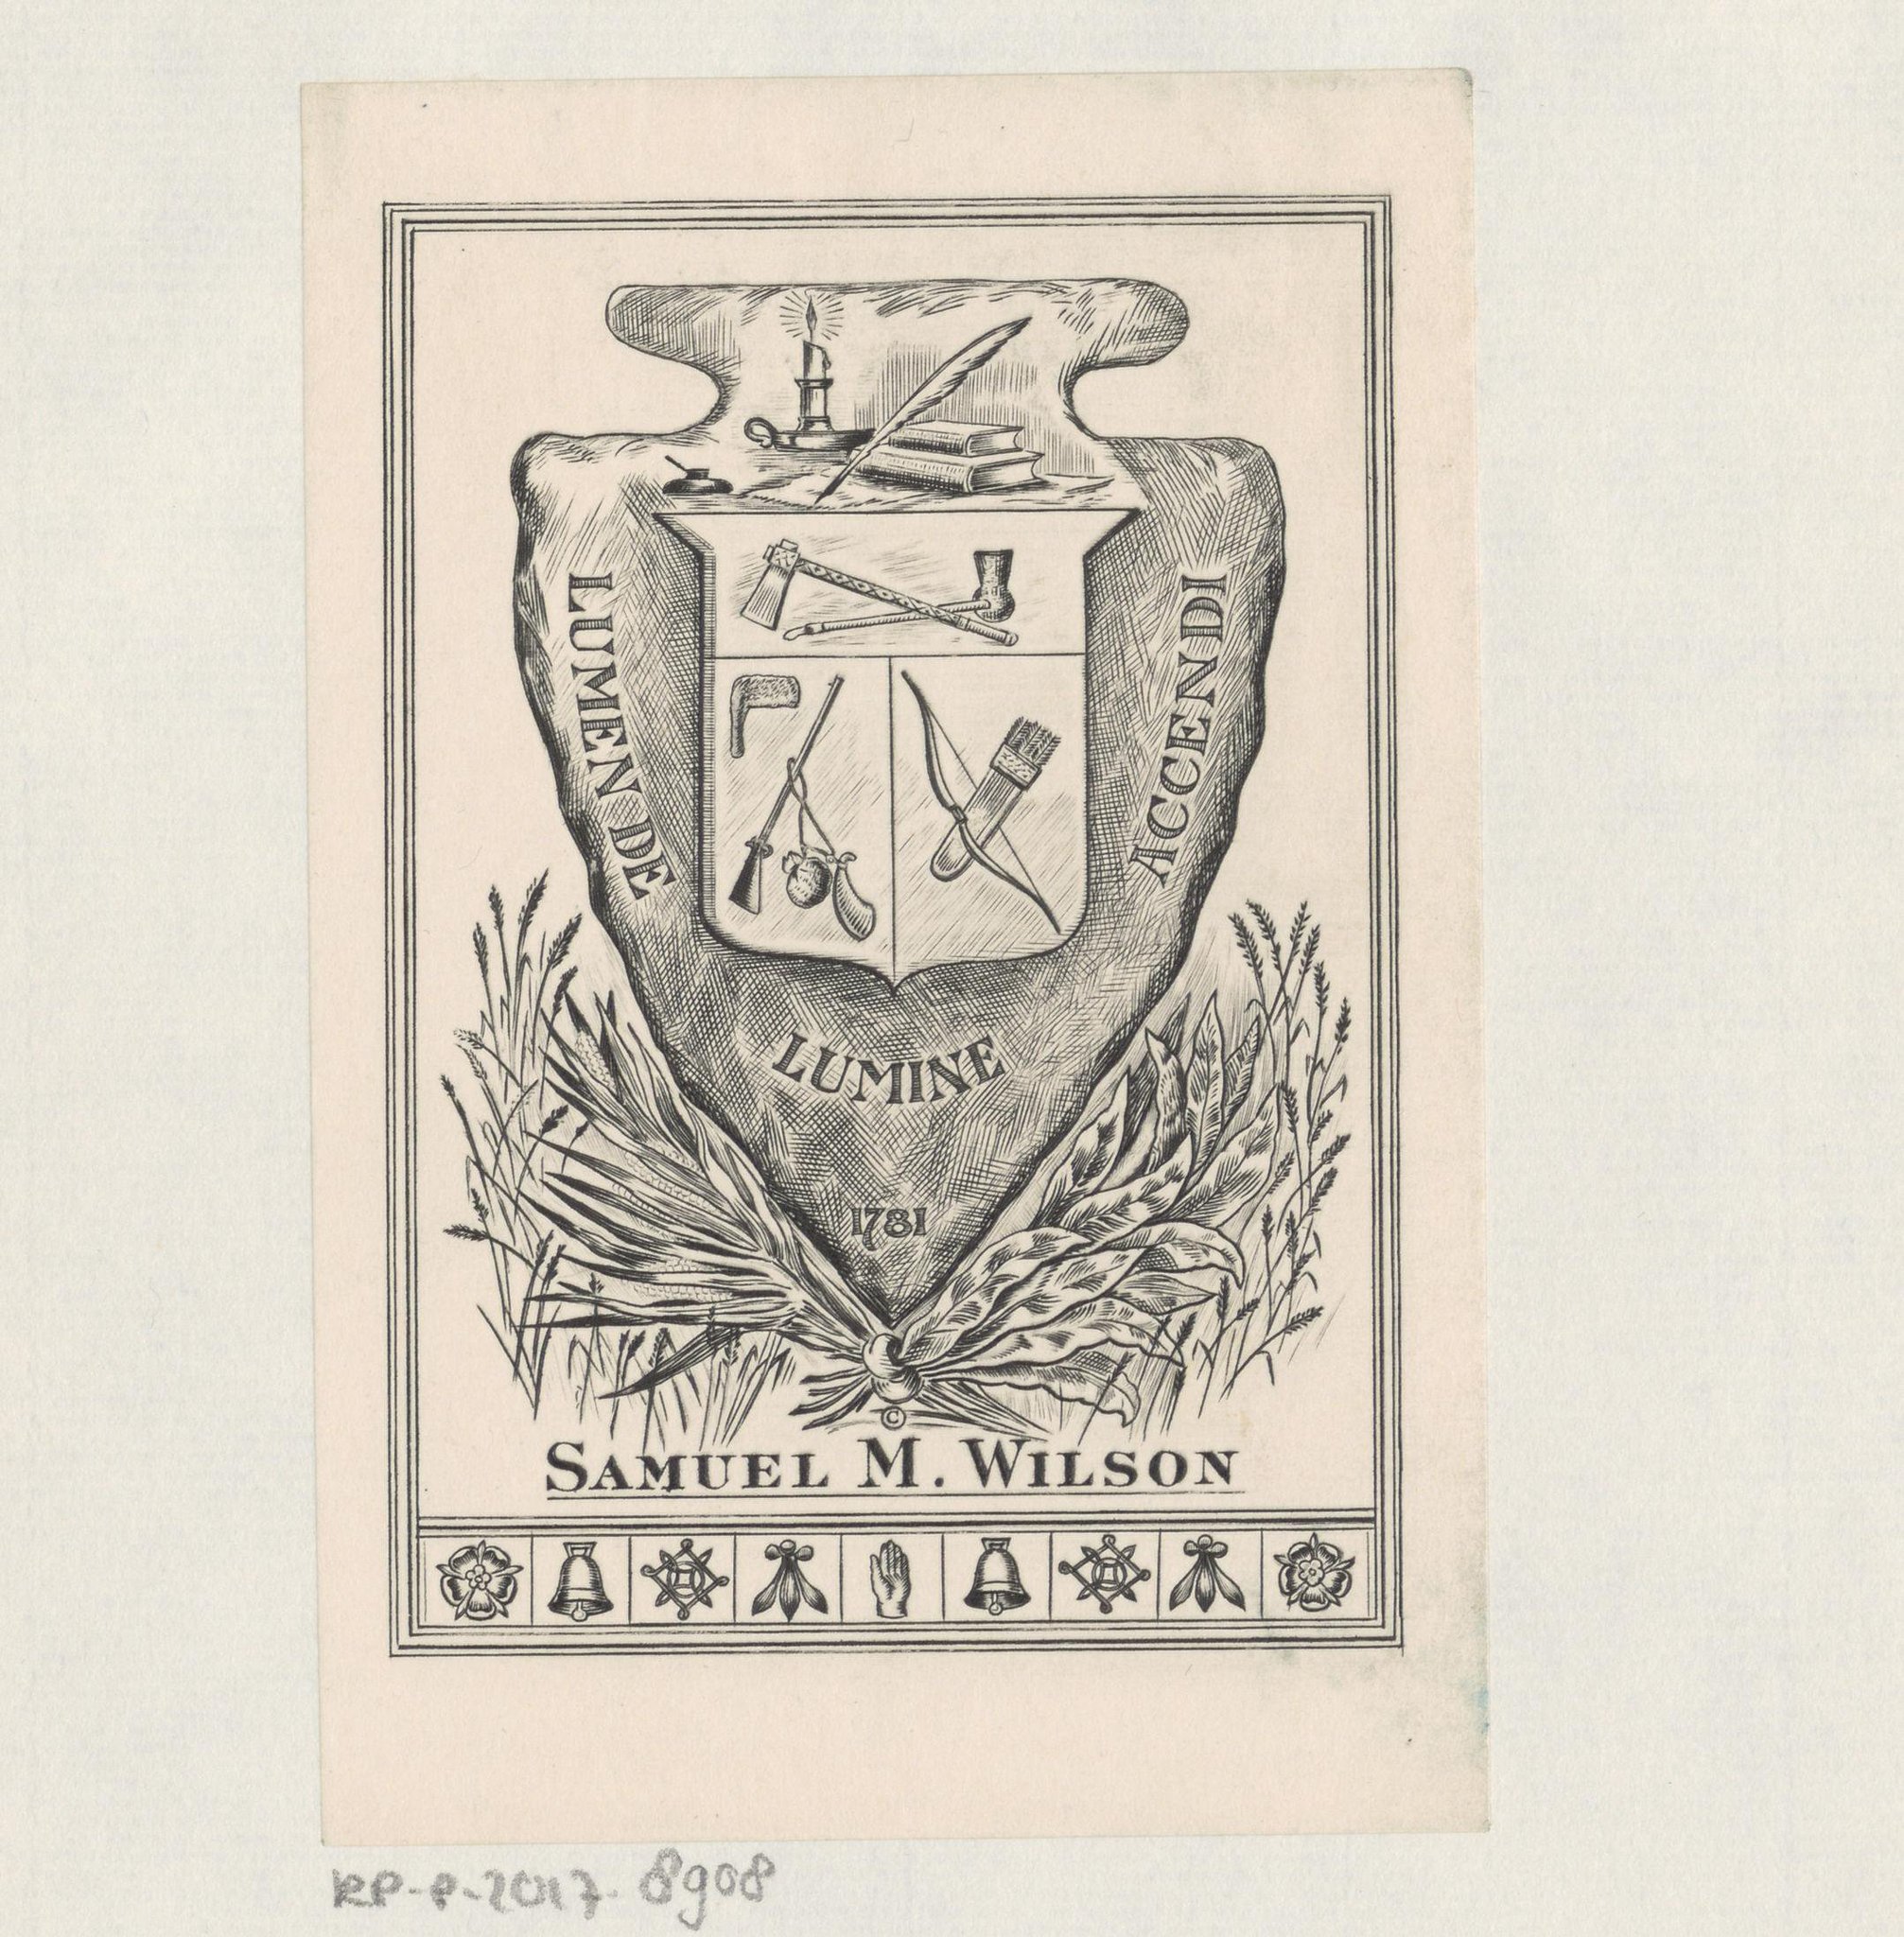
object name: bookplate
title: Lumine de lumine accendi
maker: Anonymous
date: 1900-1999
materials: paper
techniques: engraving, etching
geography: north and central america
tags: quill, tools, aids, implements ~ crafts and industries: axe, candle, archer's weapons